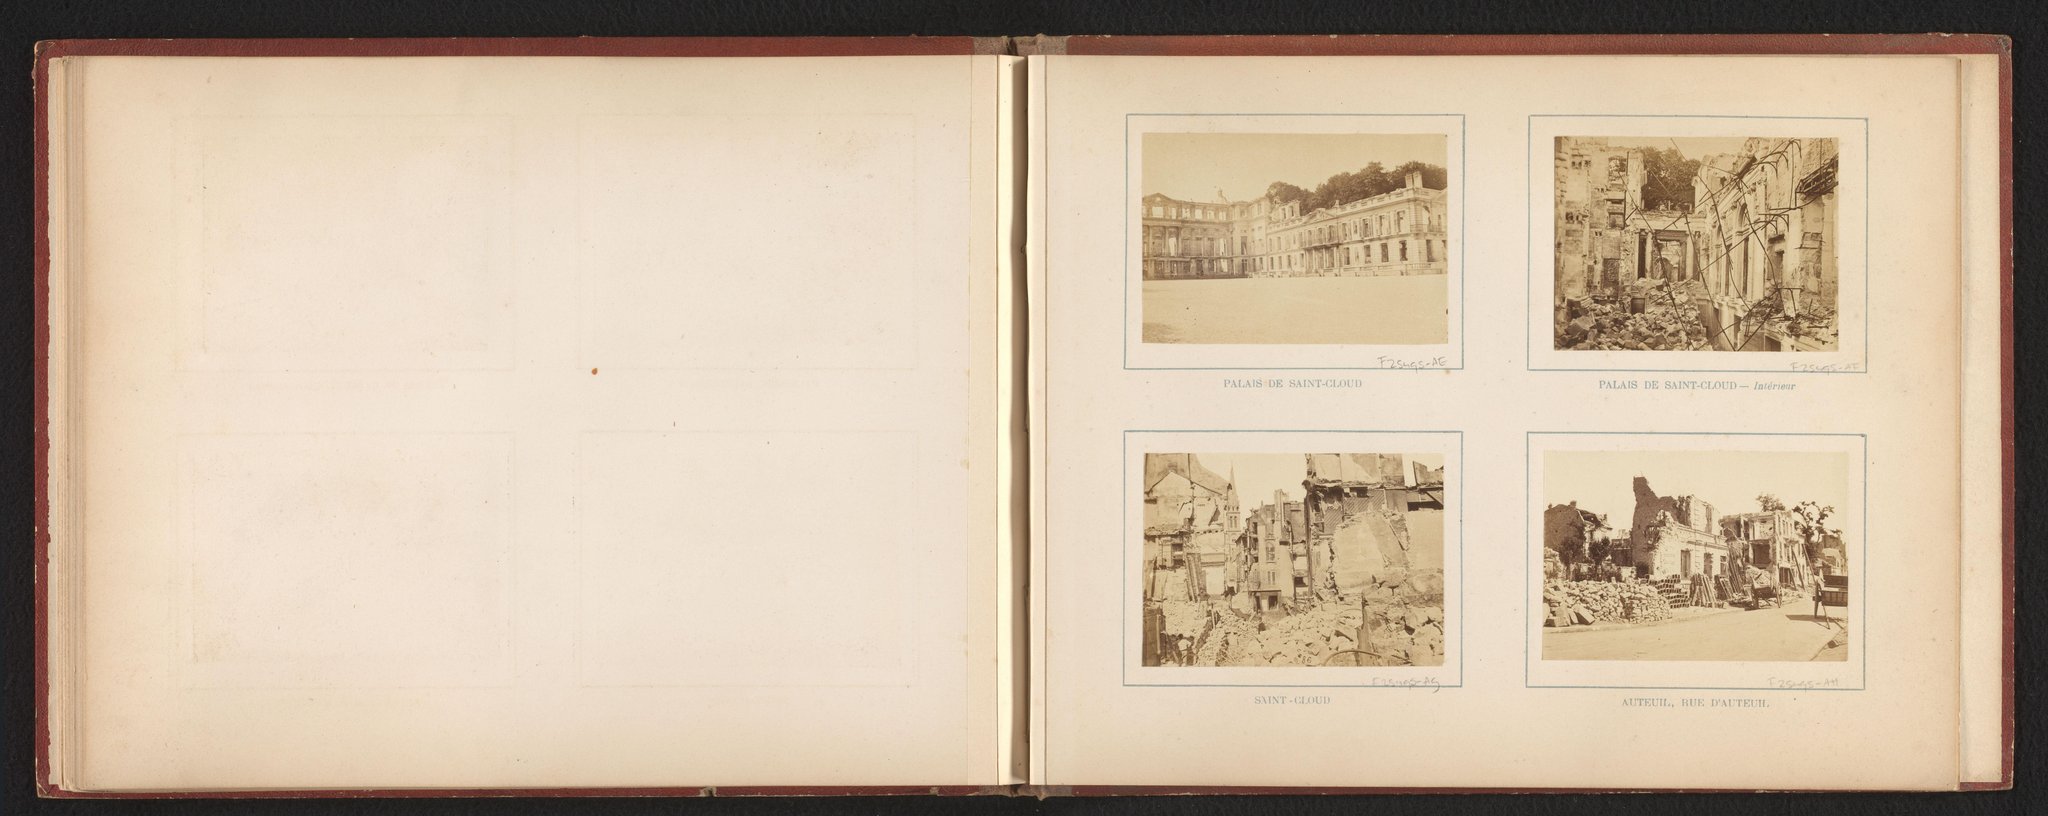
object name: page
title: Palais de Saint-Cloud - Intérieur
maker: Anonymous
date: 1870-1871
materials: paper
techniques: albumen print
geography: saint-cloud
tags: ruin of a building ~ architecture